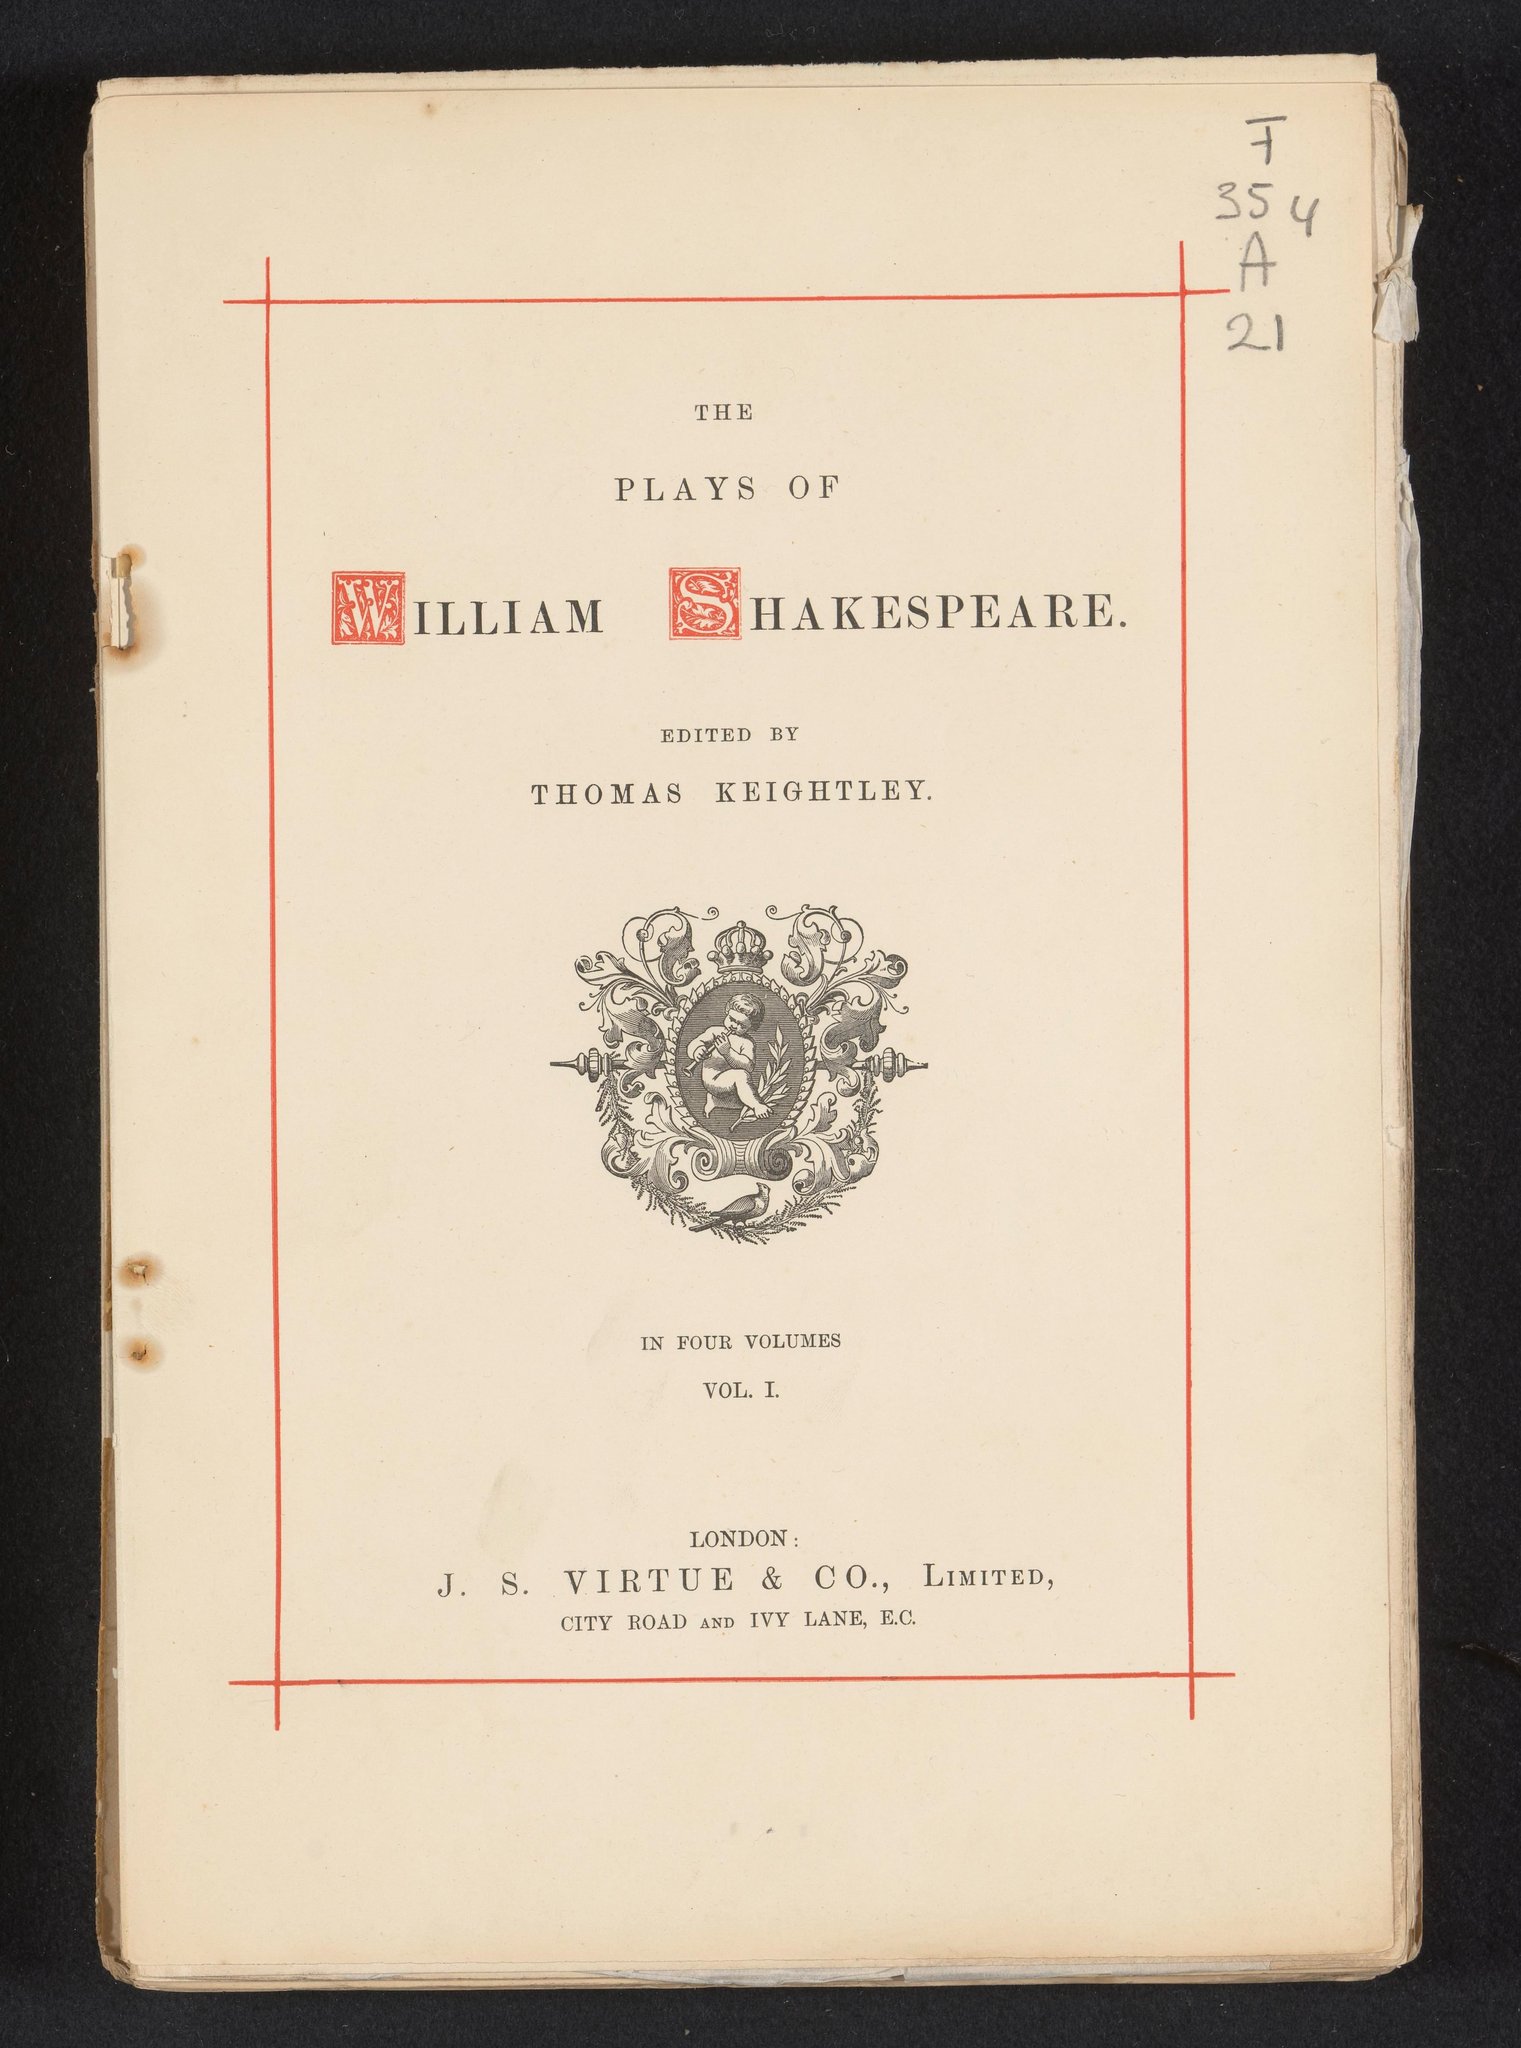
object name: book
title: The plays of William Shakespeare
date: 1890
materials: paper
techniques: photoaquatint, printing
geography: london